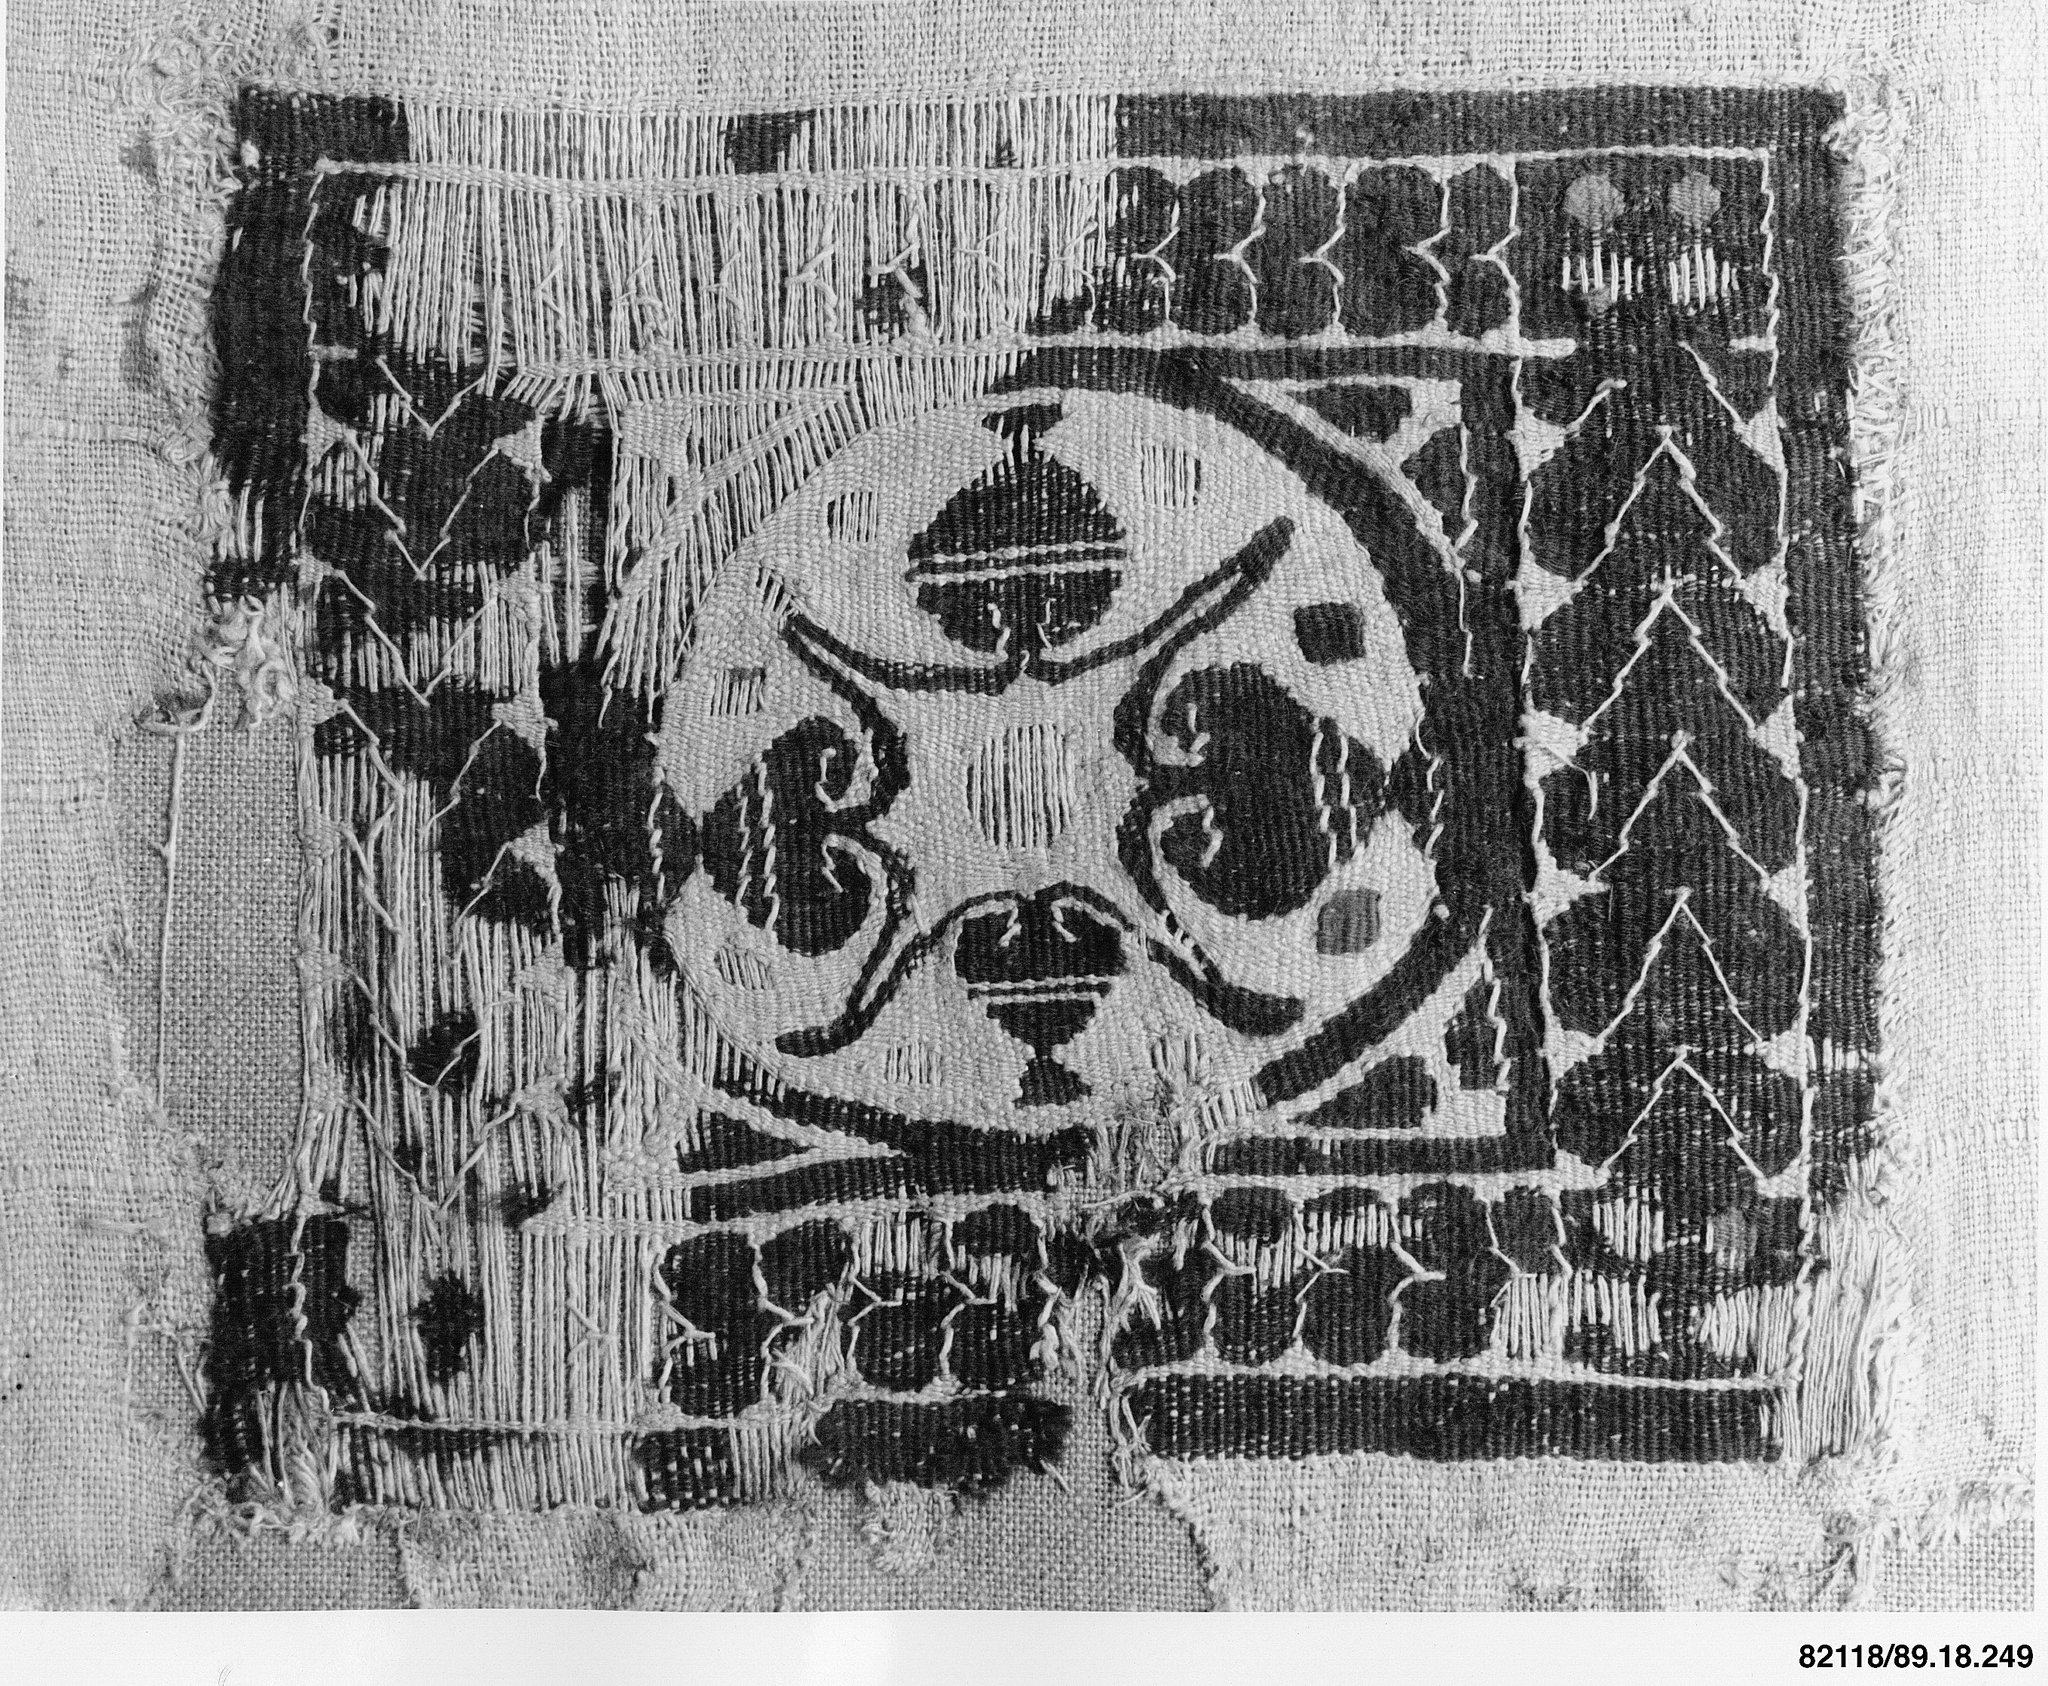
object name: textile fragment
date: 301-400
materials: linen, wool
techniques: weave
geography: egypt